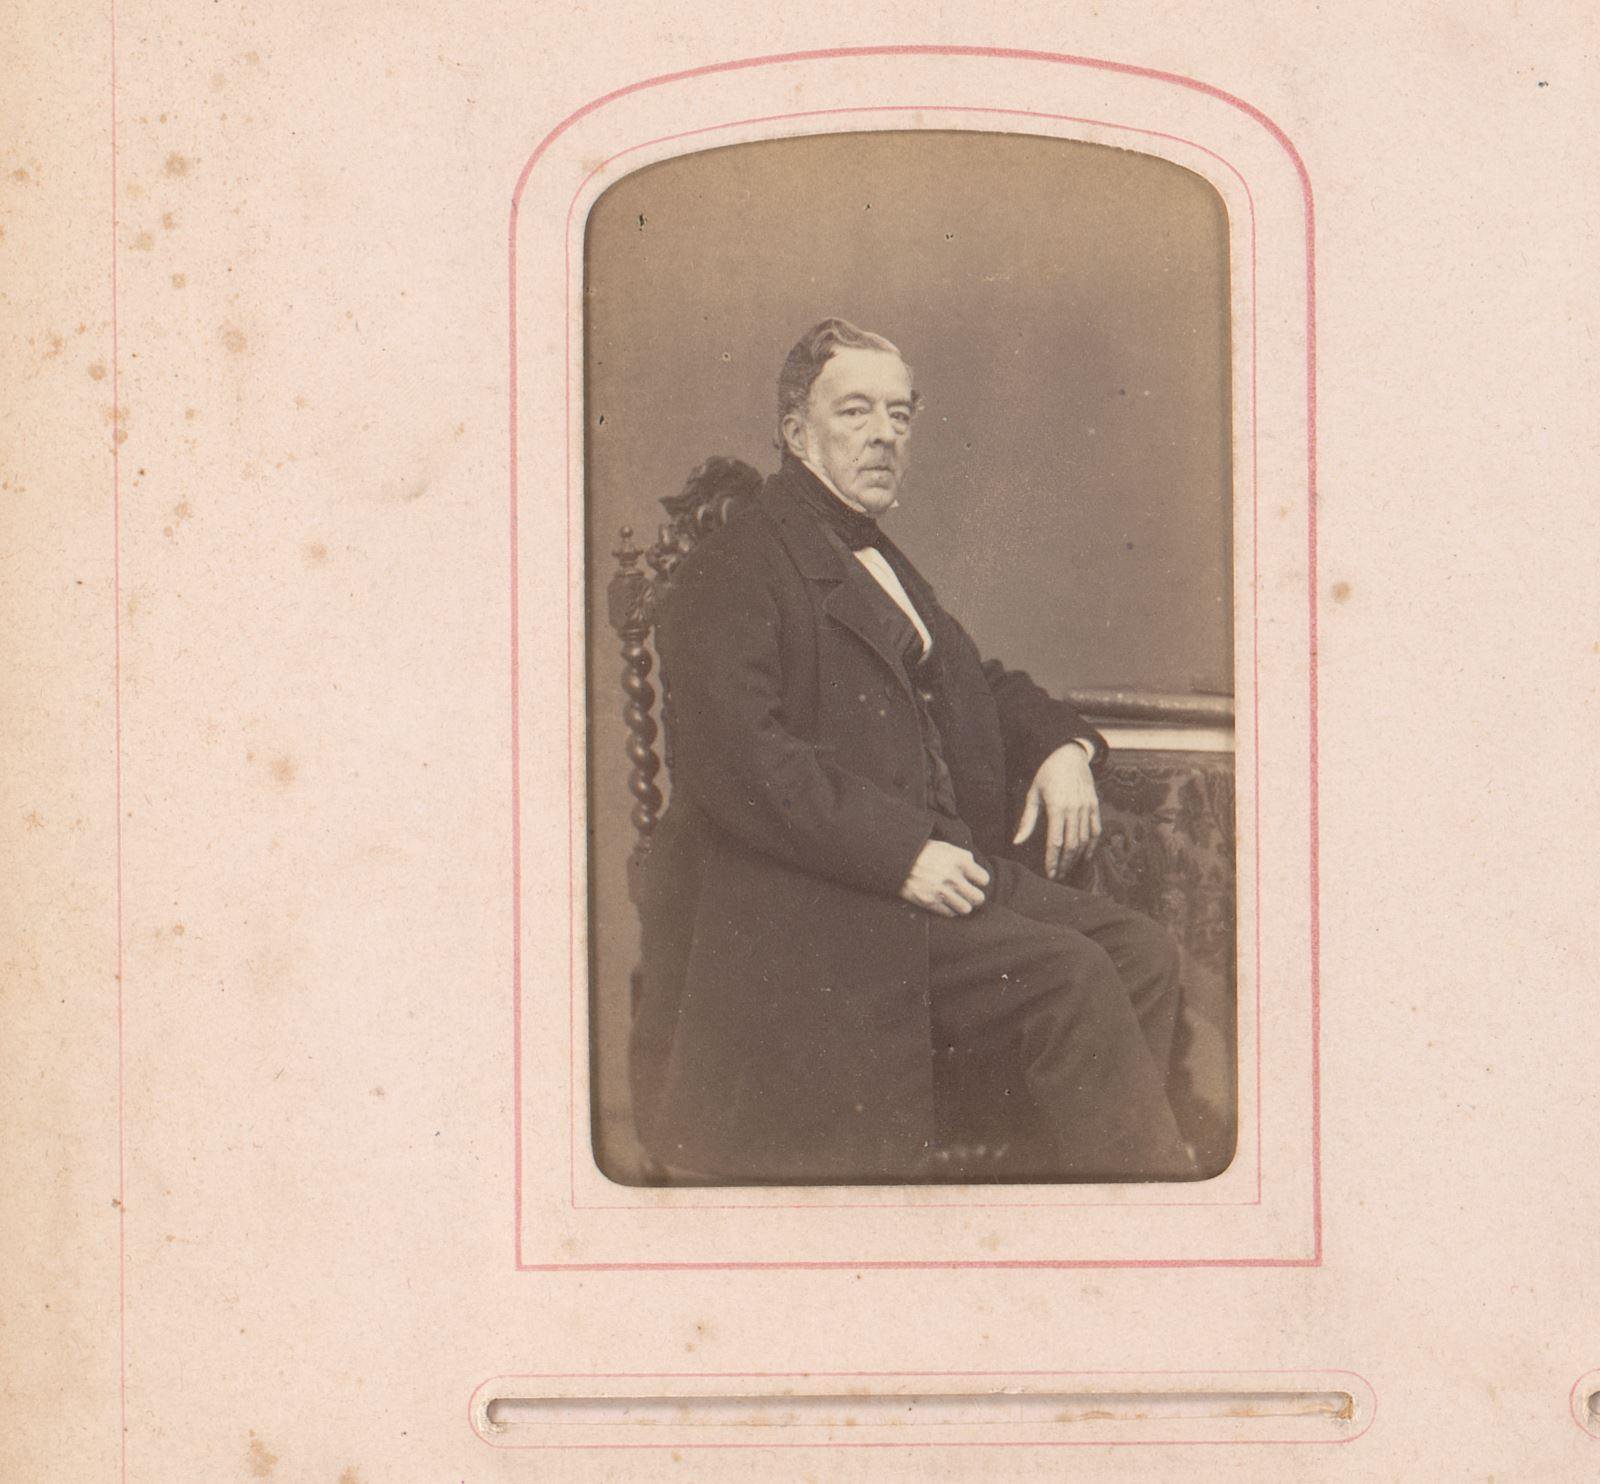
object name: carte de visite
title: Portret van een man zittend aan tafel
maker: herman bückmann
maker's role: fotograaf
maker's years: 1820-1884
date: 1855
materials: cardboard, paper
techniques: albumen print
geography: the hague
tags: adult man, historical persons, the hague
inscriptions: inscription: ‘Herman Buckmann/ Photogr. de S. M. la Reine/ La Haye.’